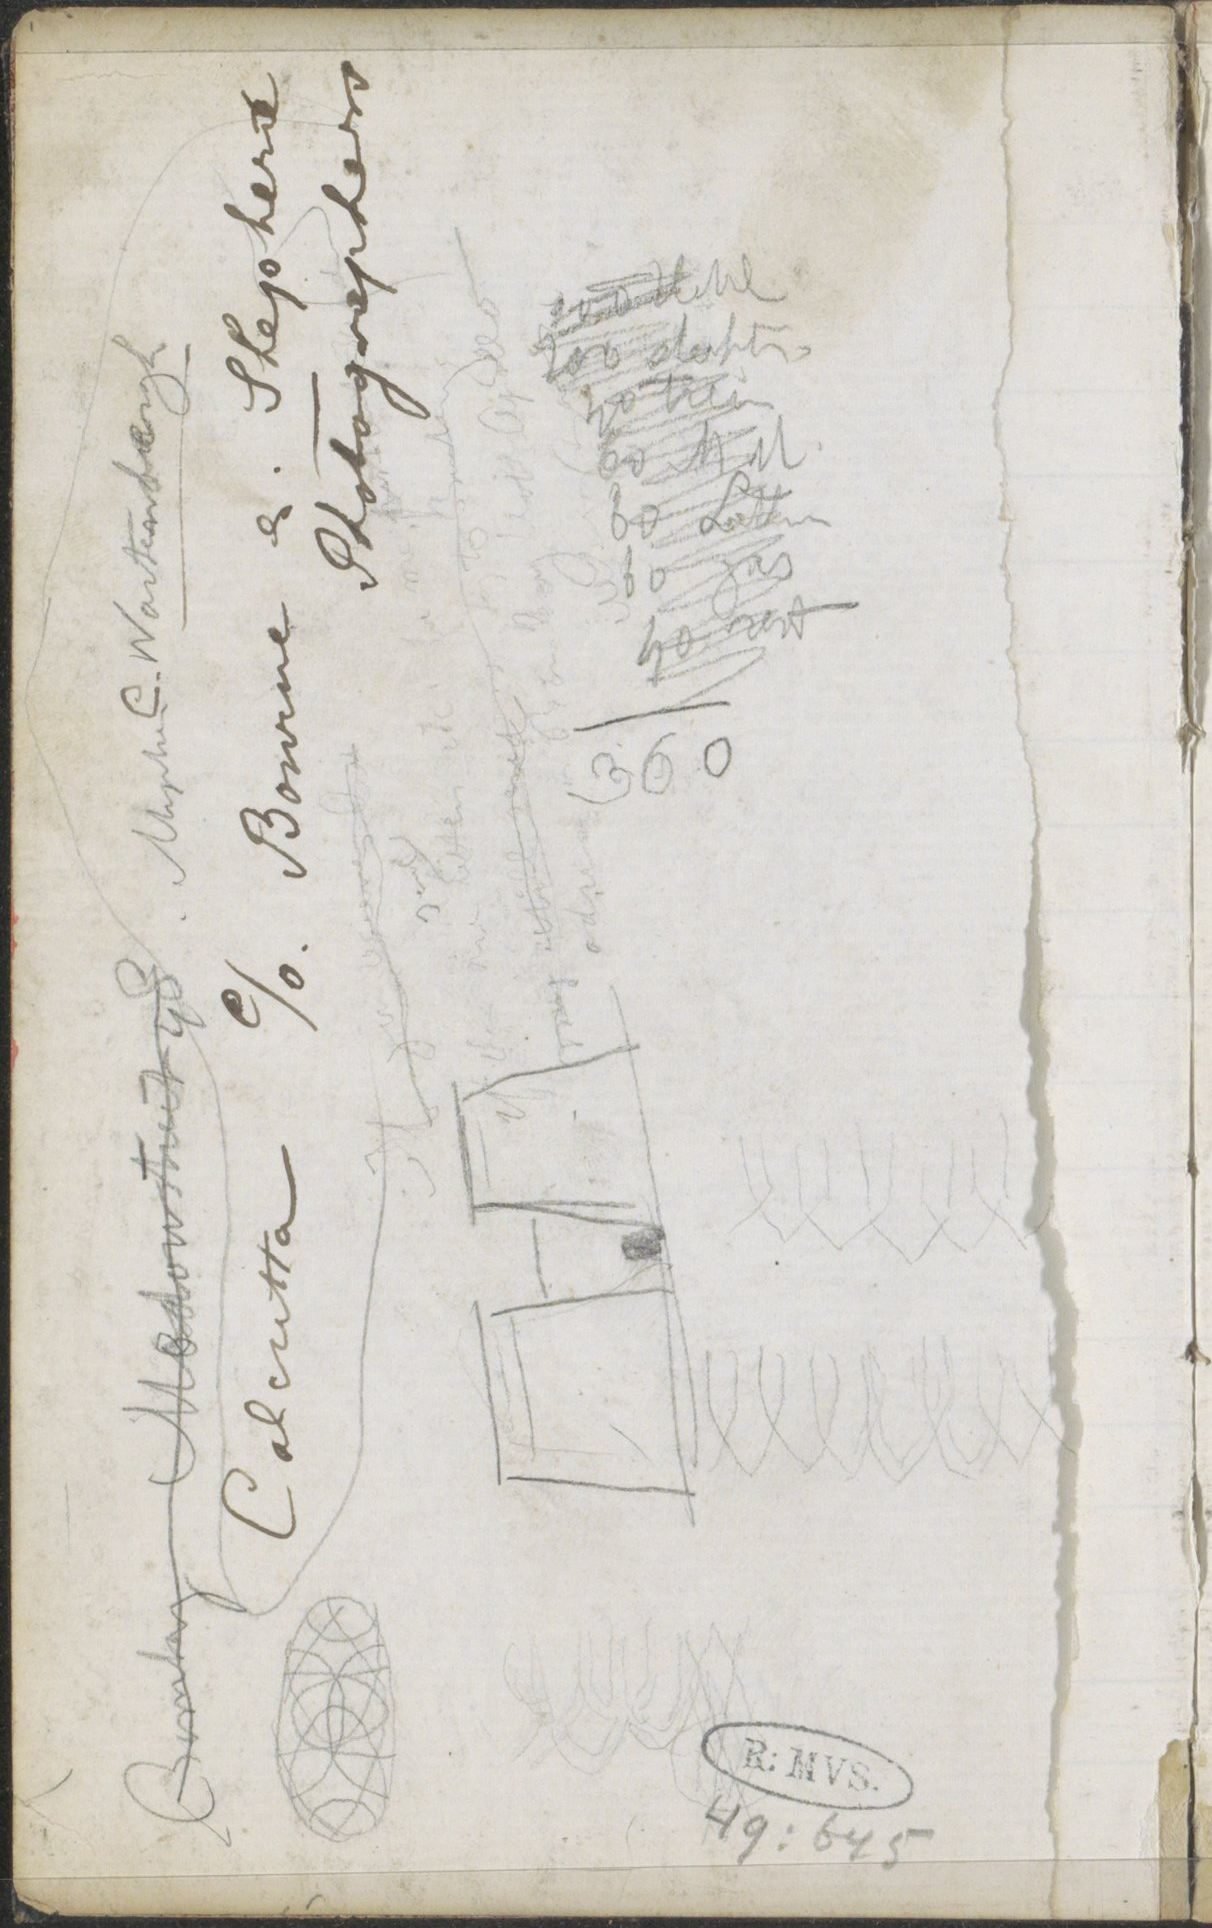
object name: sketchbook leaf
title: Studie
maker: marius bauer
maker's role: draughtsman, print maker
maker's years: 1867-1932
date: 1897-1898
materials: pencil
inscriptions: annotation: ‘Bombay Modowstreet 48 [...]/ Calcutta c/o Bourne & Shepherd/ Photographers/ [...]’, collector's mark: Lugt 2228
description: Pagina 1 uit een schetsboek met 62 bladen.